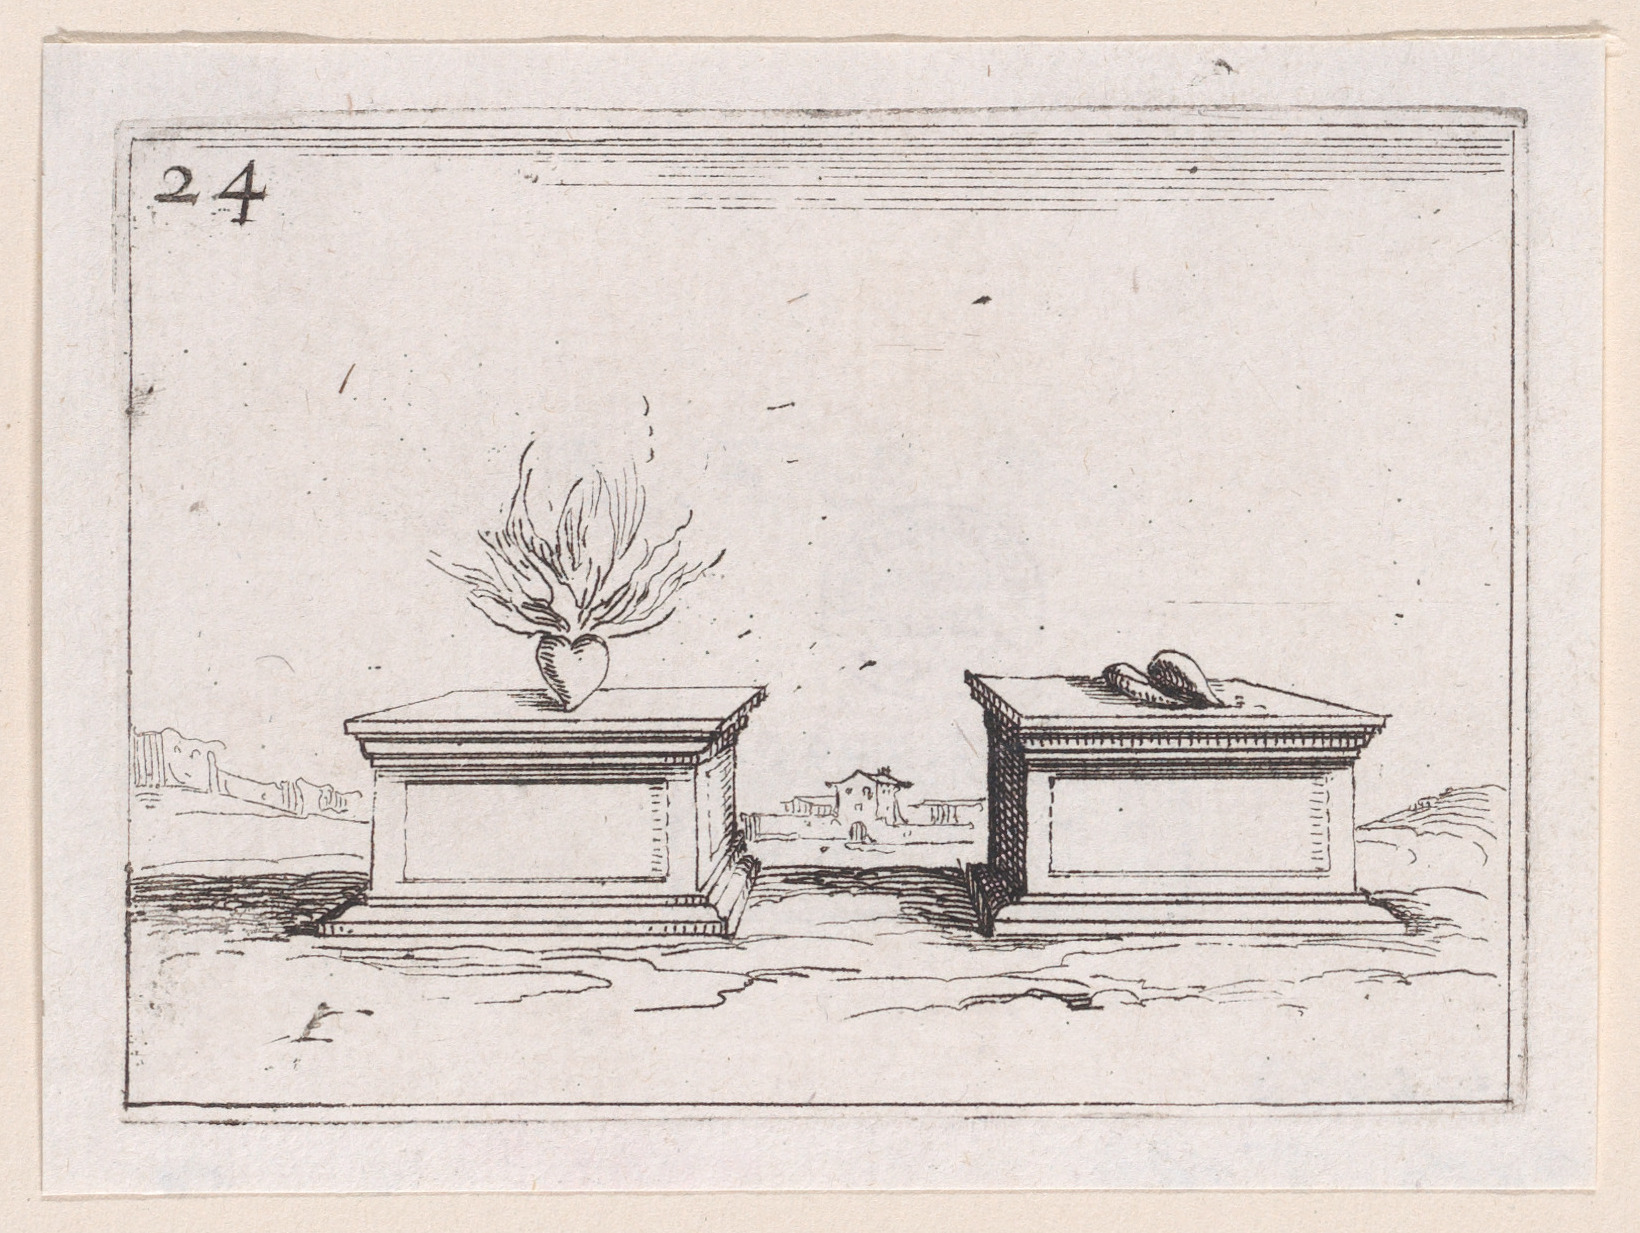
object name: print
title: Les Deux Coeurs (The Two Hearts), plate 24 from "Lux Claustri ou La Lumière du Cloitre" (The Light of the Cloisters)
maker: jacques callot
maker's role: artist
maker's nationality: french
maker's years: 1592-1635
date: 1621-1635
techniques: etching